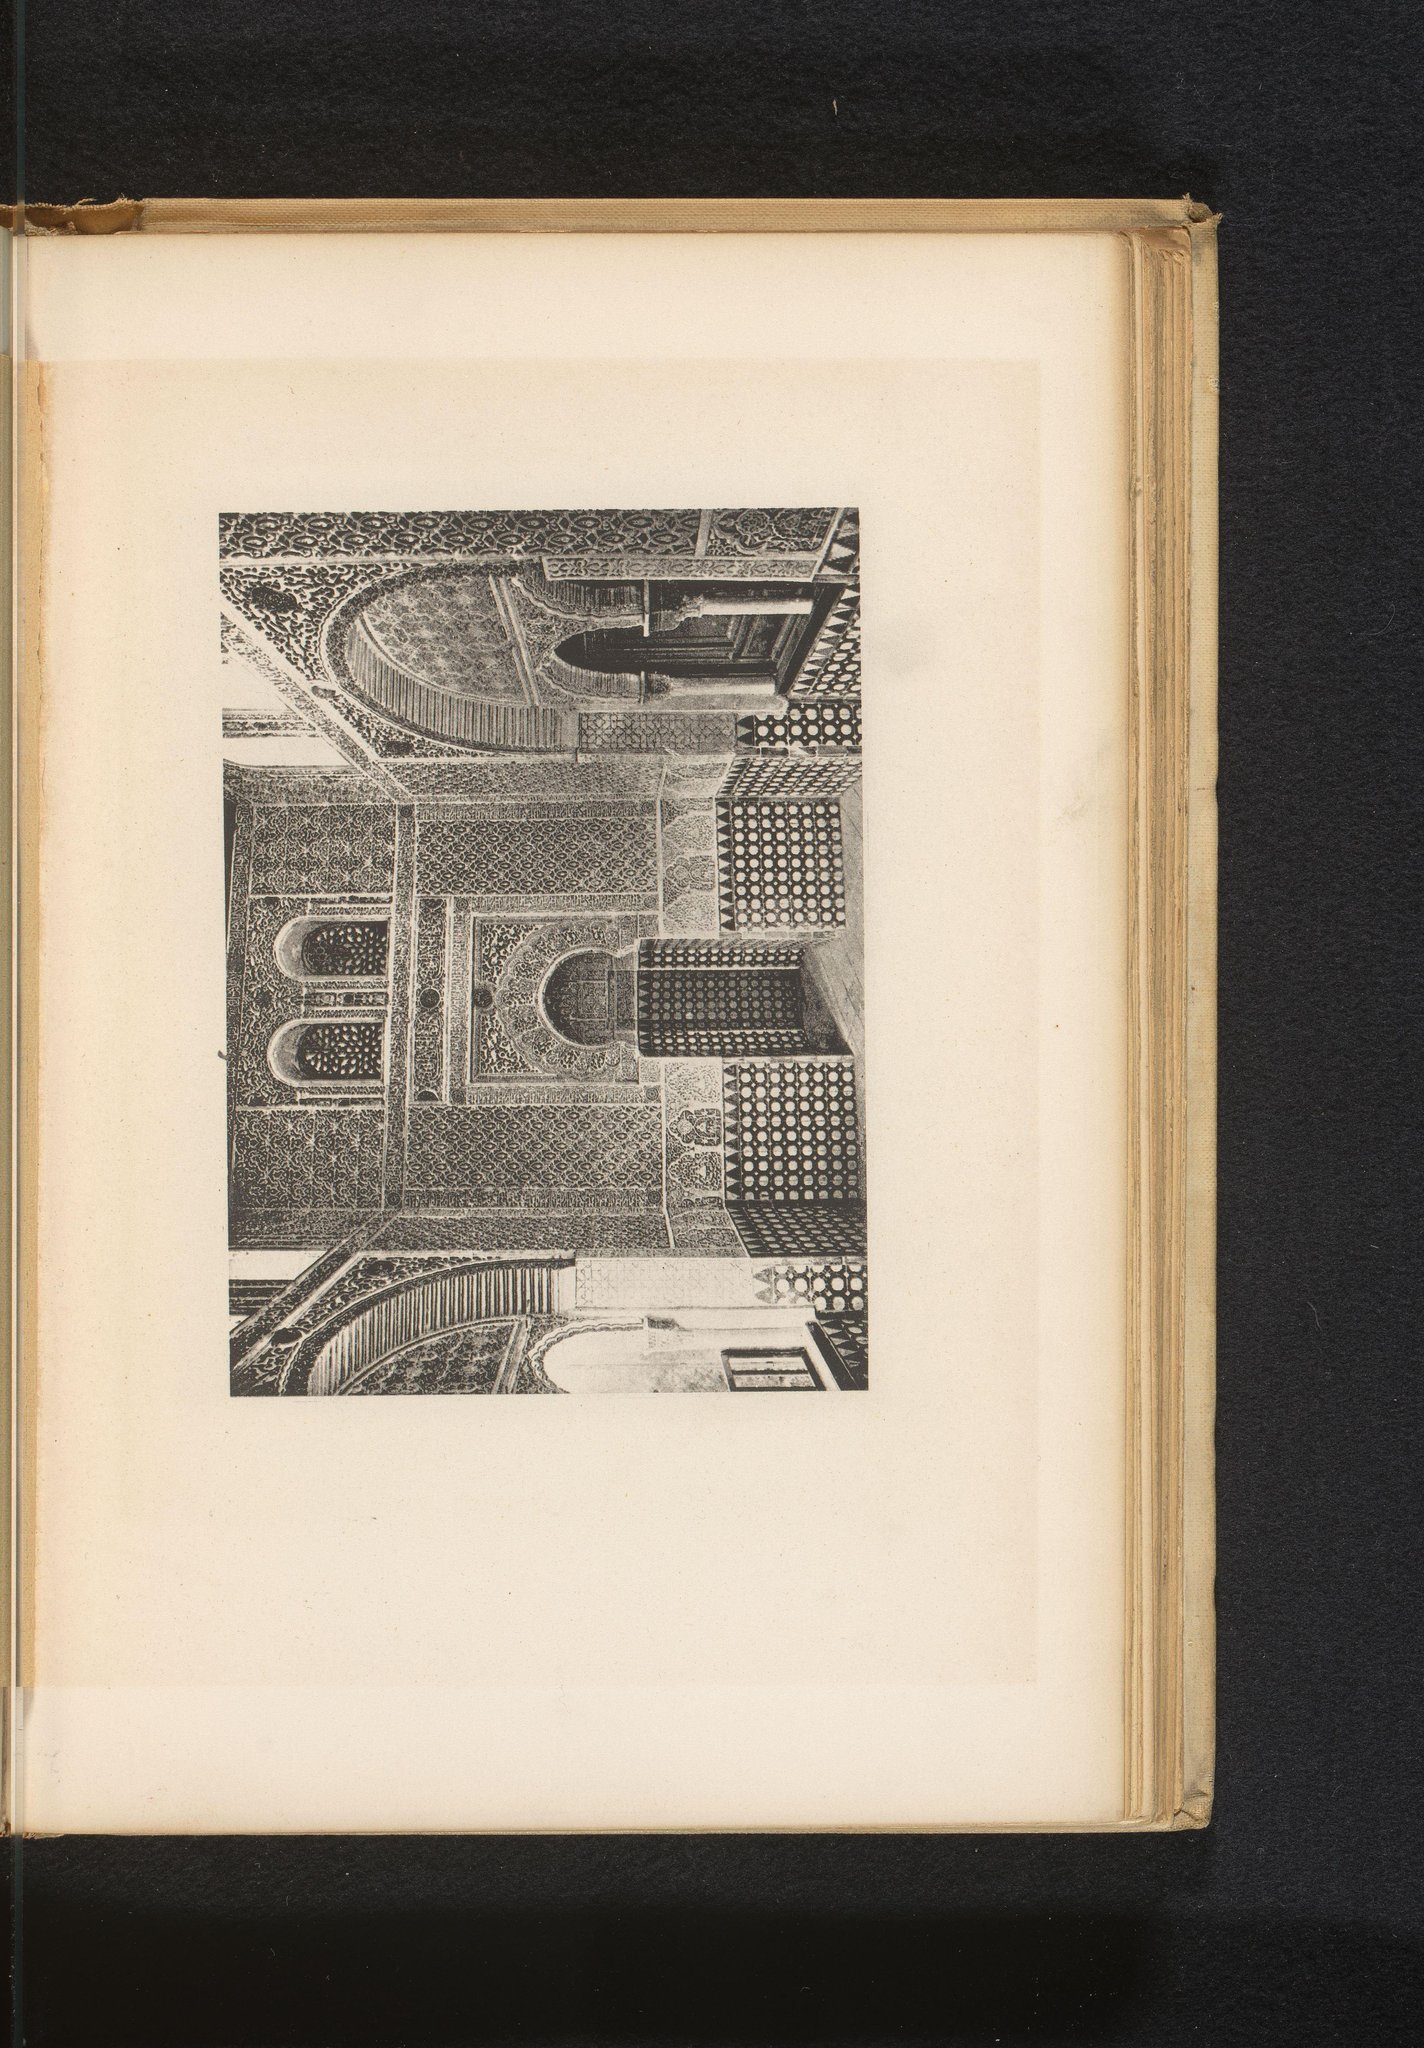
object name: photomechanical print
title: Mihrab, in a Little Mosque, near the Palace of the Alhambra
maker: Anonymous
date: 1884-1894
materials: paper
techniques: photoaquatint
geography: granada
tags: temple, shrine ~ islam, mohammedanism